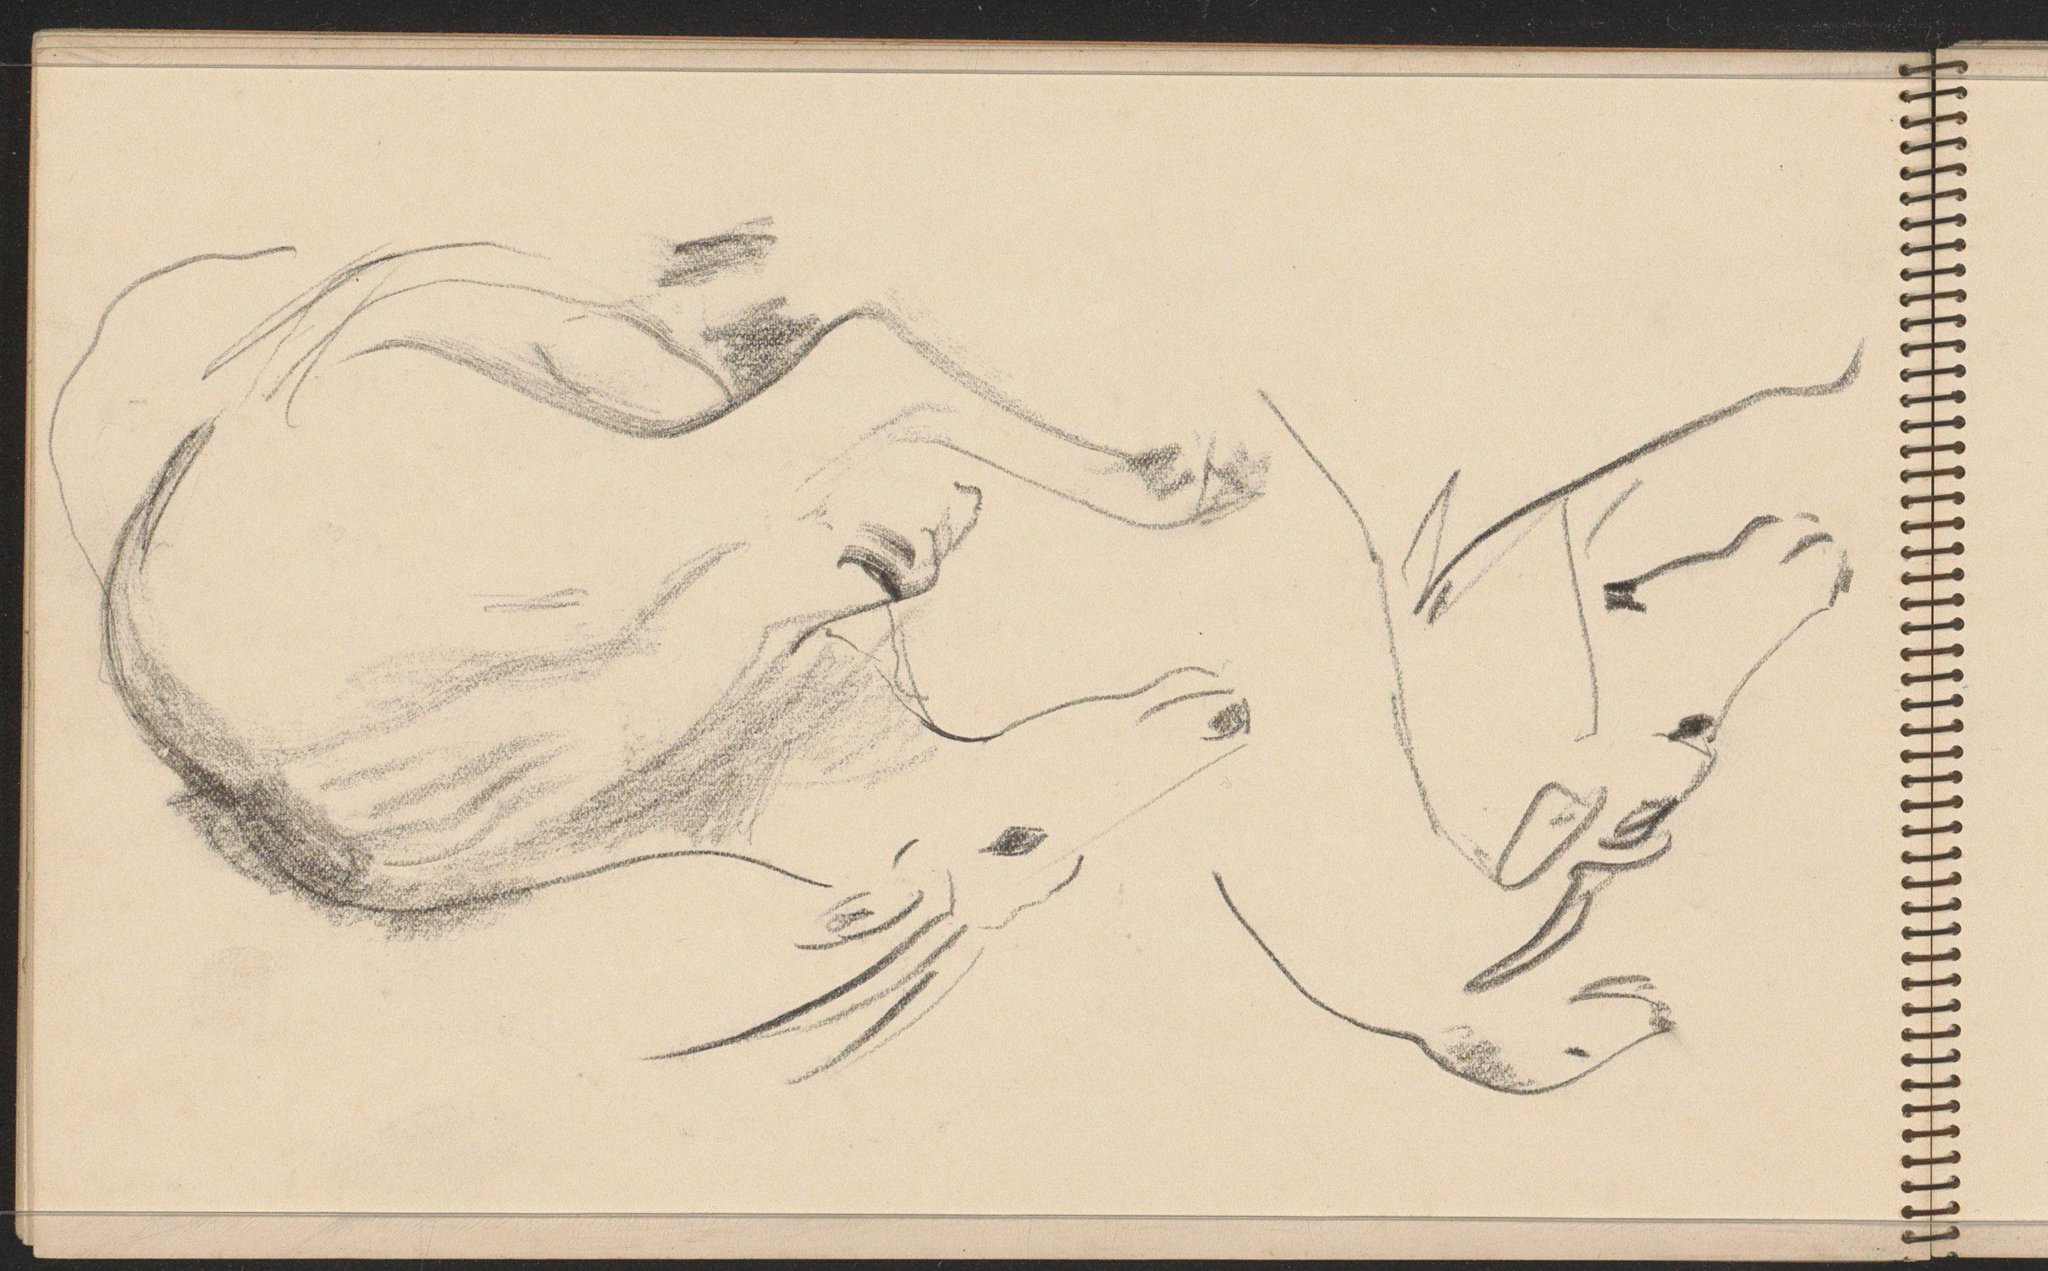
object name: sketchbook leaf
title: Twee geiten en een hond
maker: carel adolph lion cachet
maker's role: draughtsman, print maker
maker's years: 1864-1945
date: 1930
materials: chalk, paper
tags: goat, dog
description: Blad 4 verso uit een schetsboek met 14 bladen.